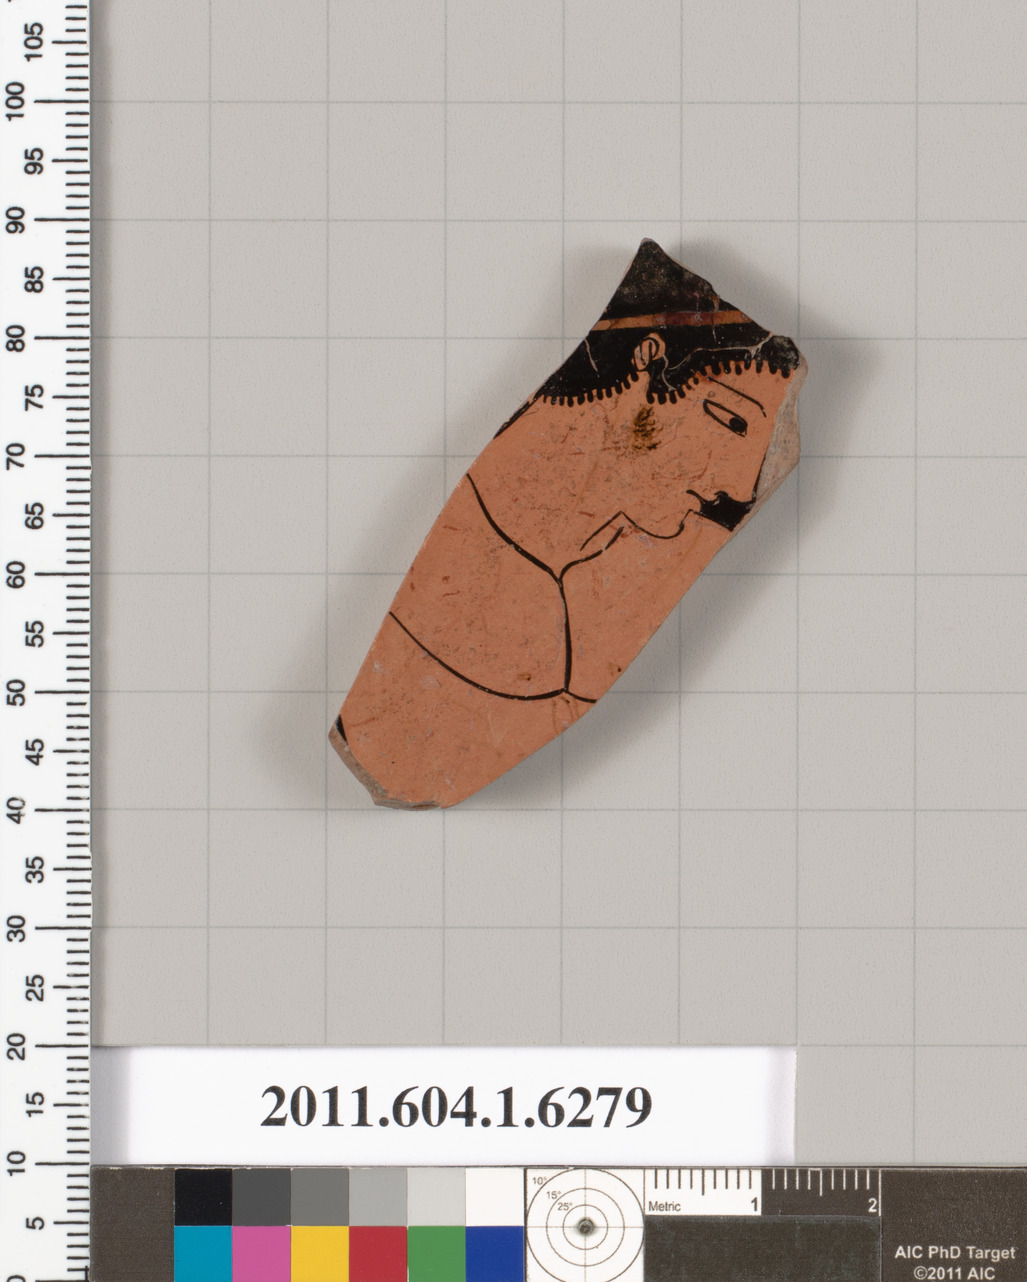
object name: kylix fragment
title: Terracotta fragment of a kylix (drinking cup)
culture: greek, attic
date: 500-480 BCE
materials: terracotta